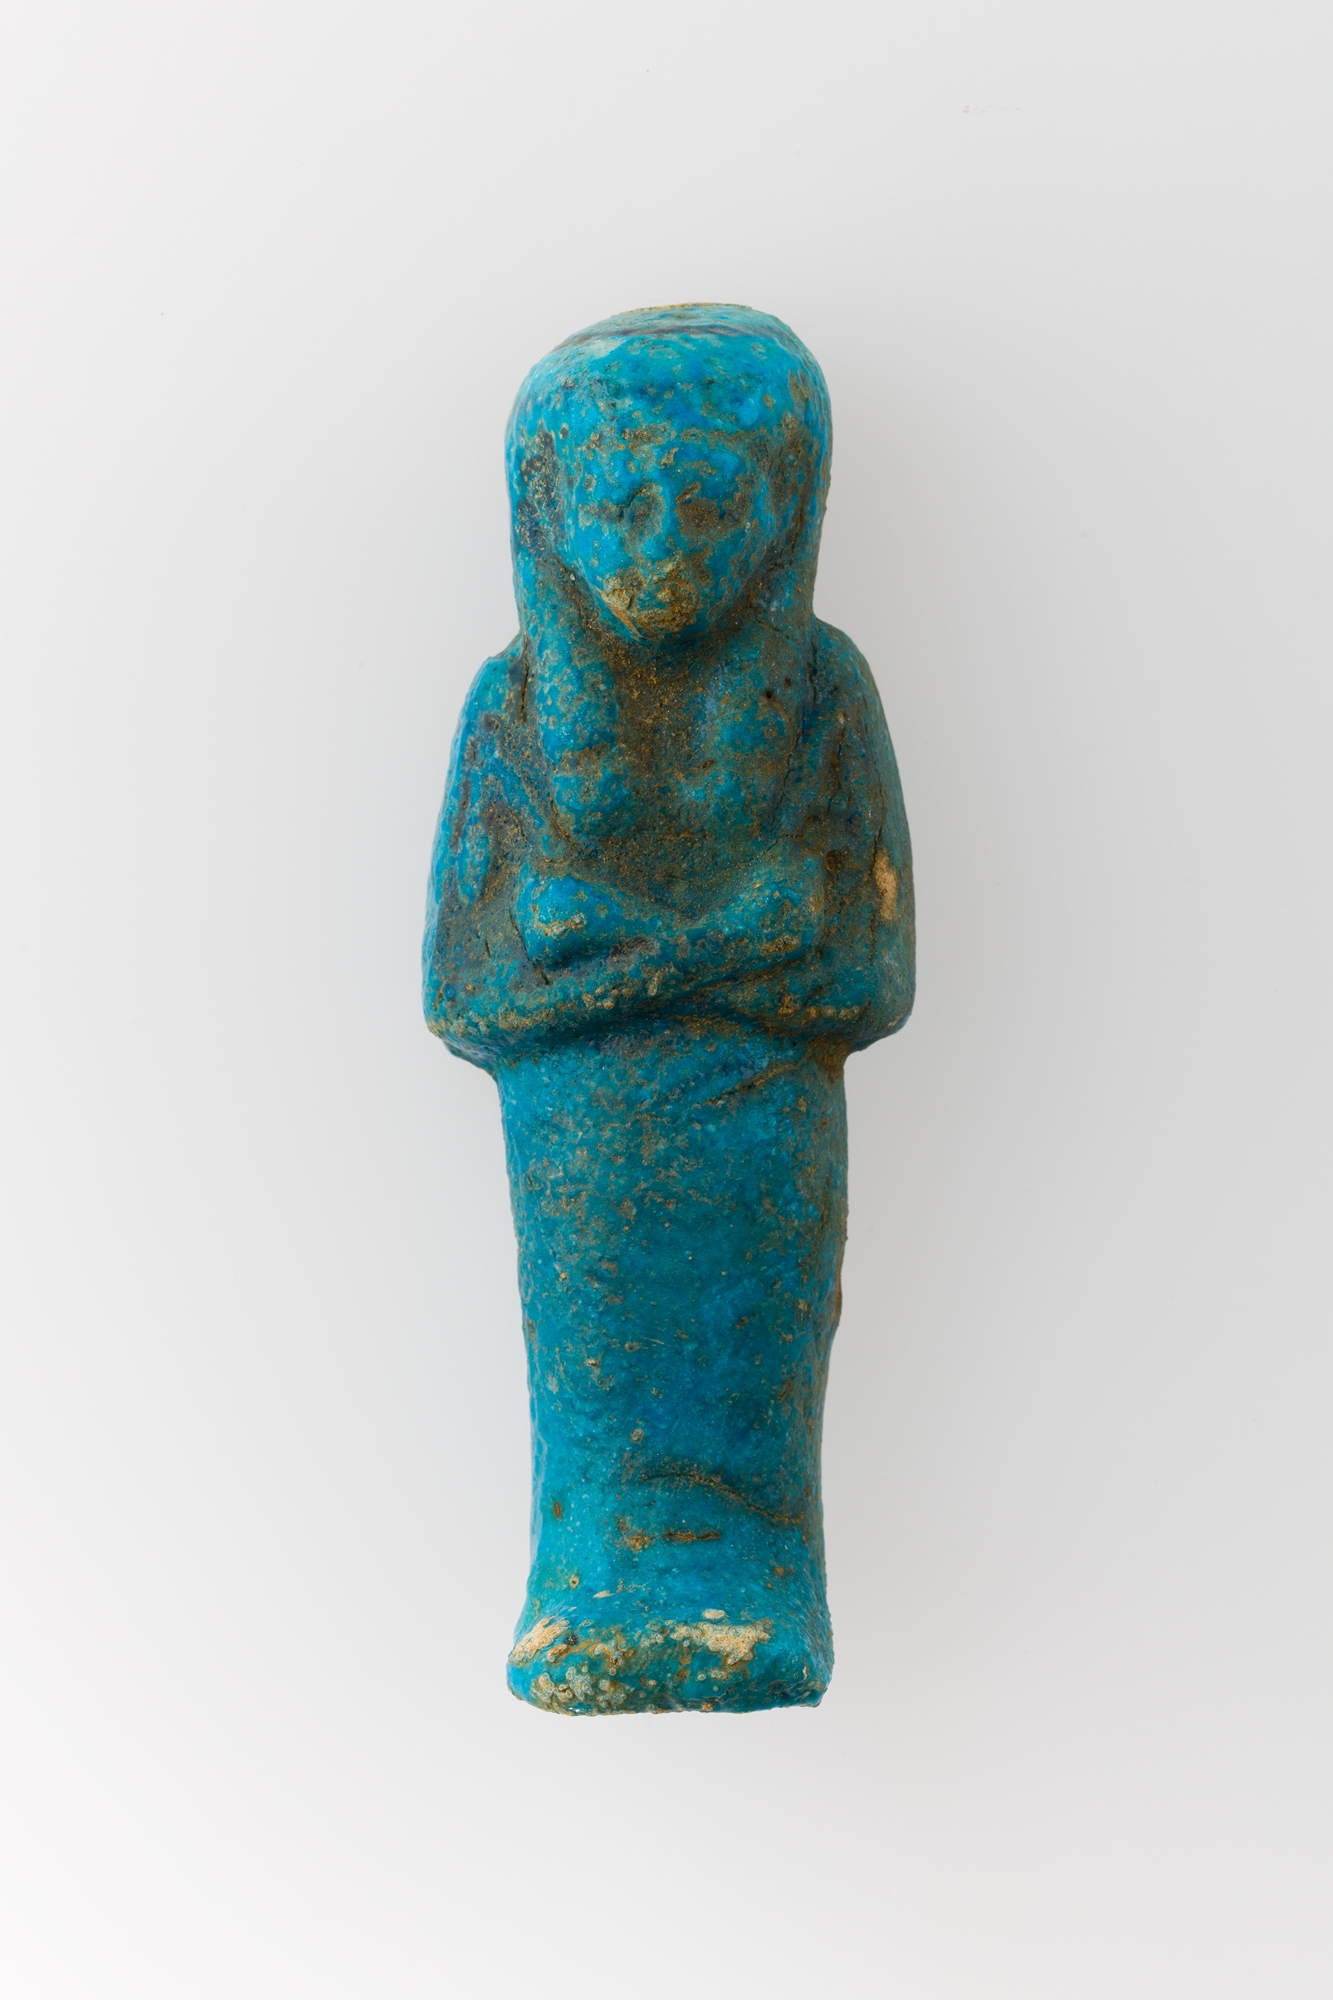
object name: shabti, henettawy c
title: Worker Shabti of Henettawy (C), Daughter of Isetemkheb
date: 990-970 BCE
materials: faience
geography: egypt